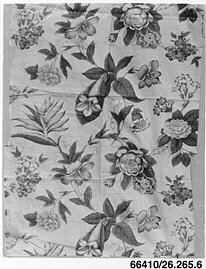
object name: floral print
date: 1830-1870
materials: cotton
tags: flowers